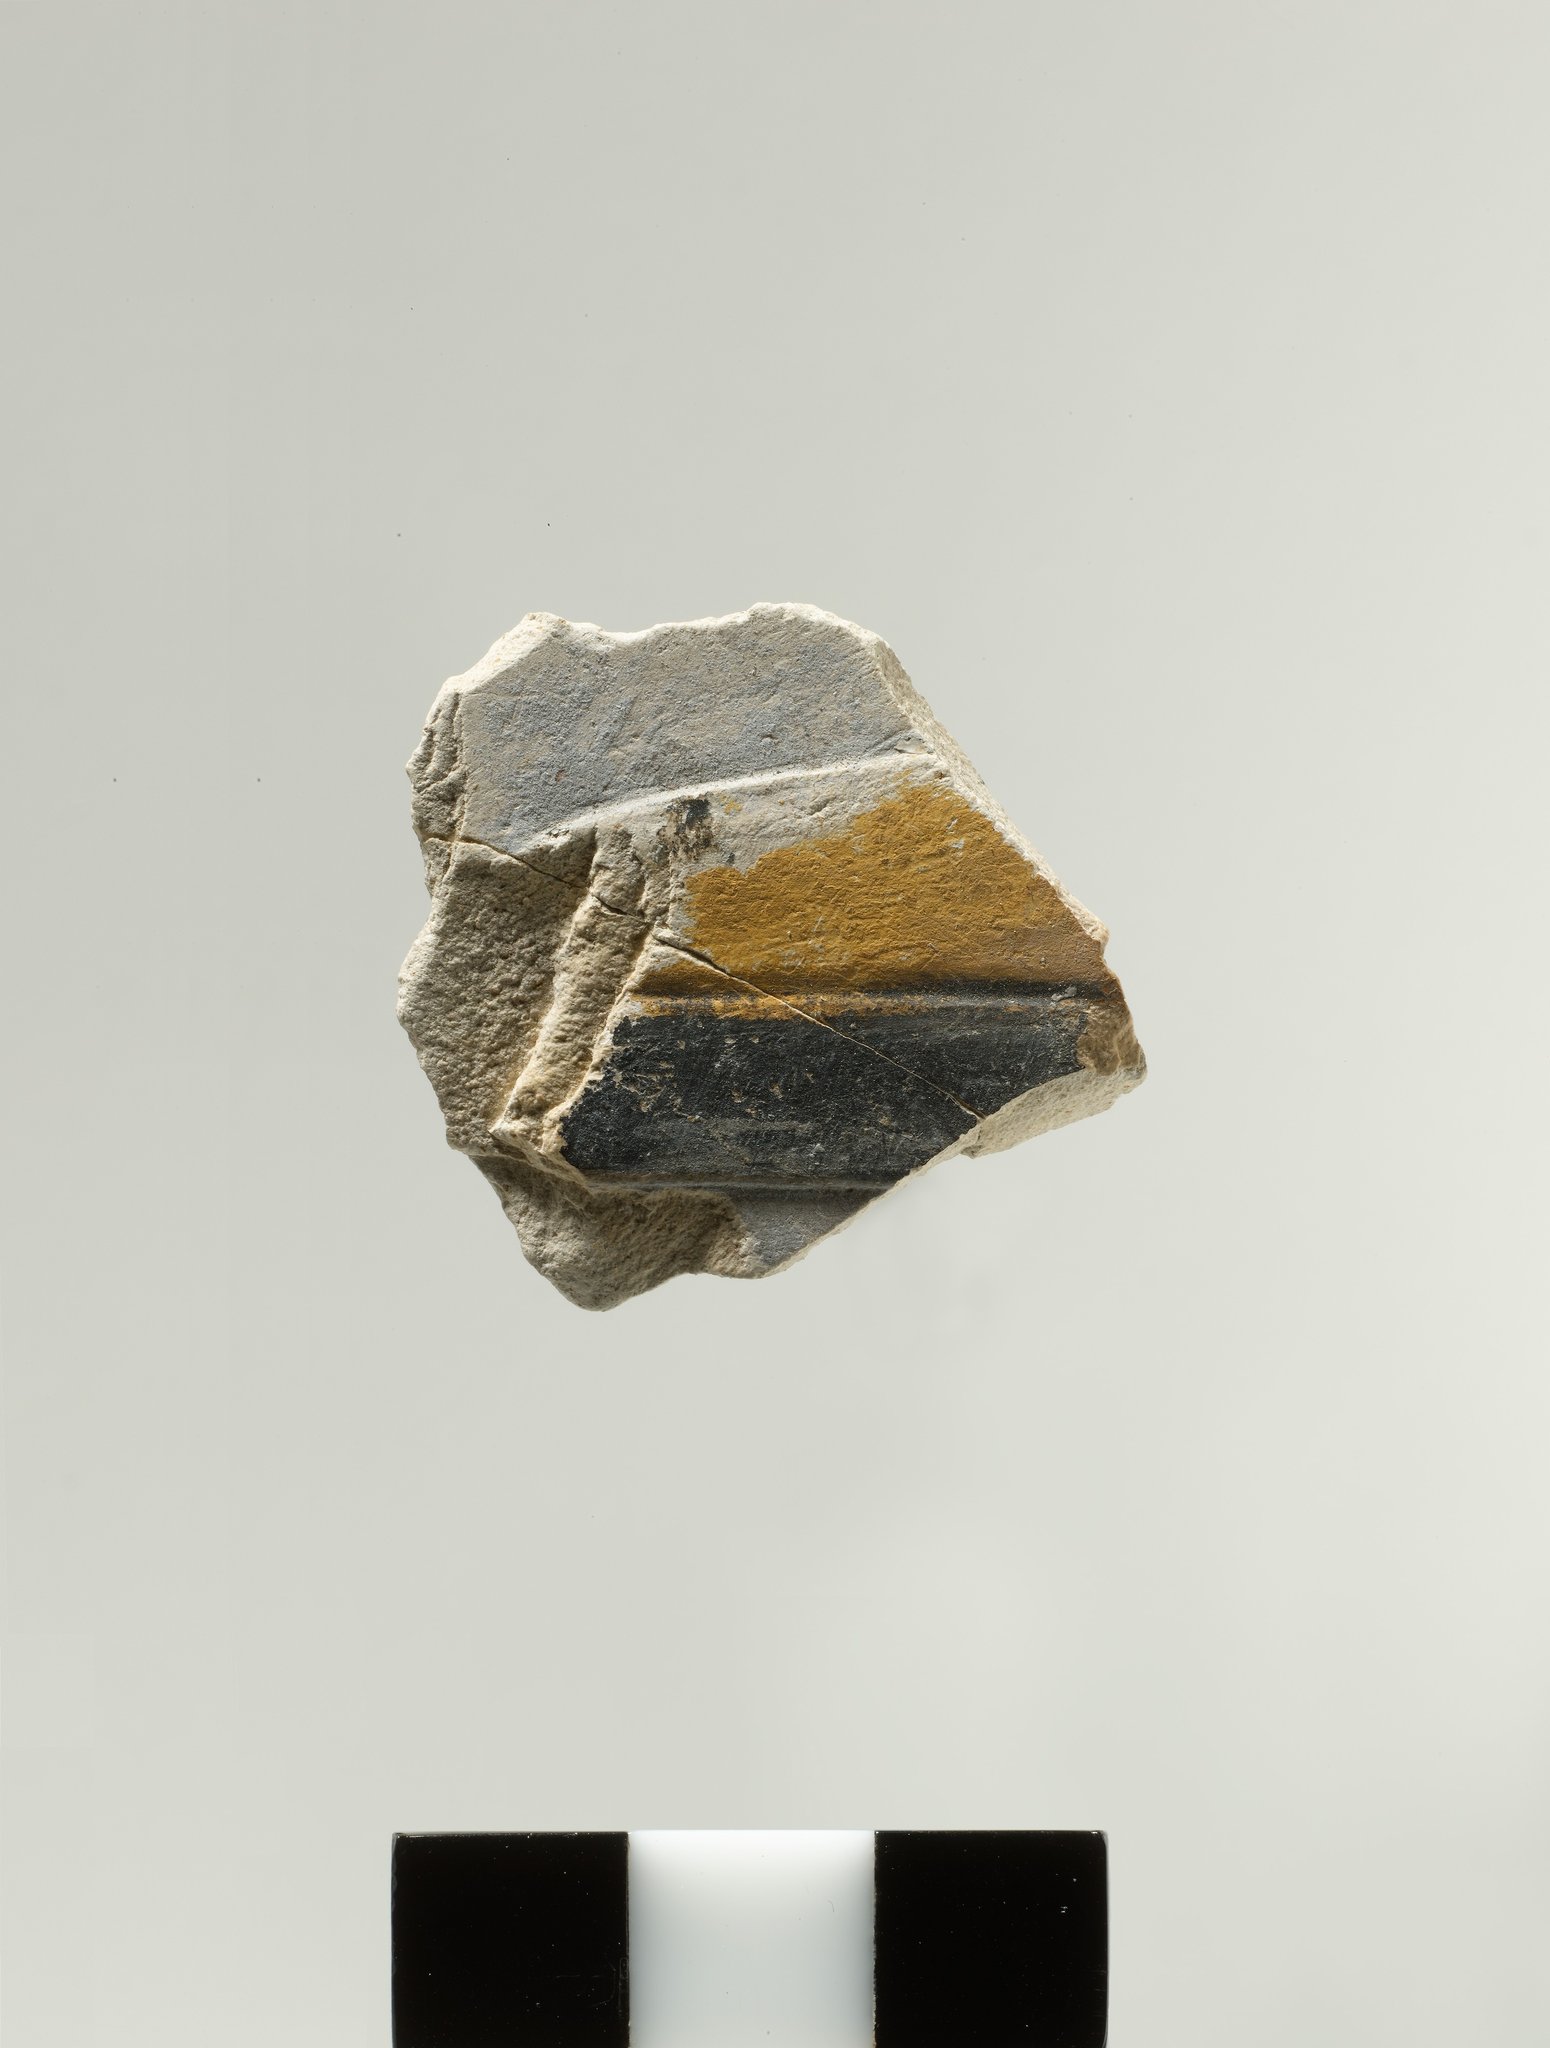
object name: relief fragment, tomb of meketre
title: Reliefs from the tomb of Meketre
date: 1981-1975 BCE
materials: limestone, paint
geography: egypt